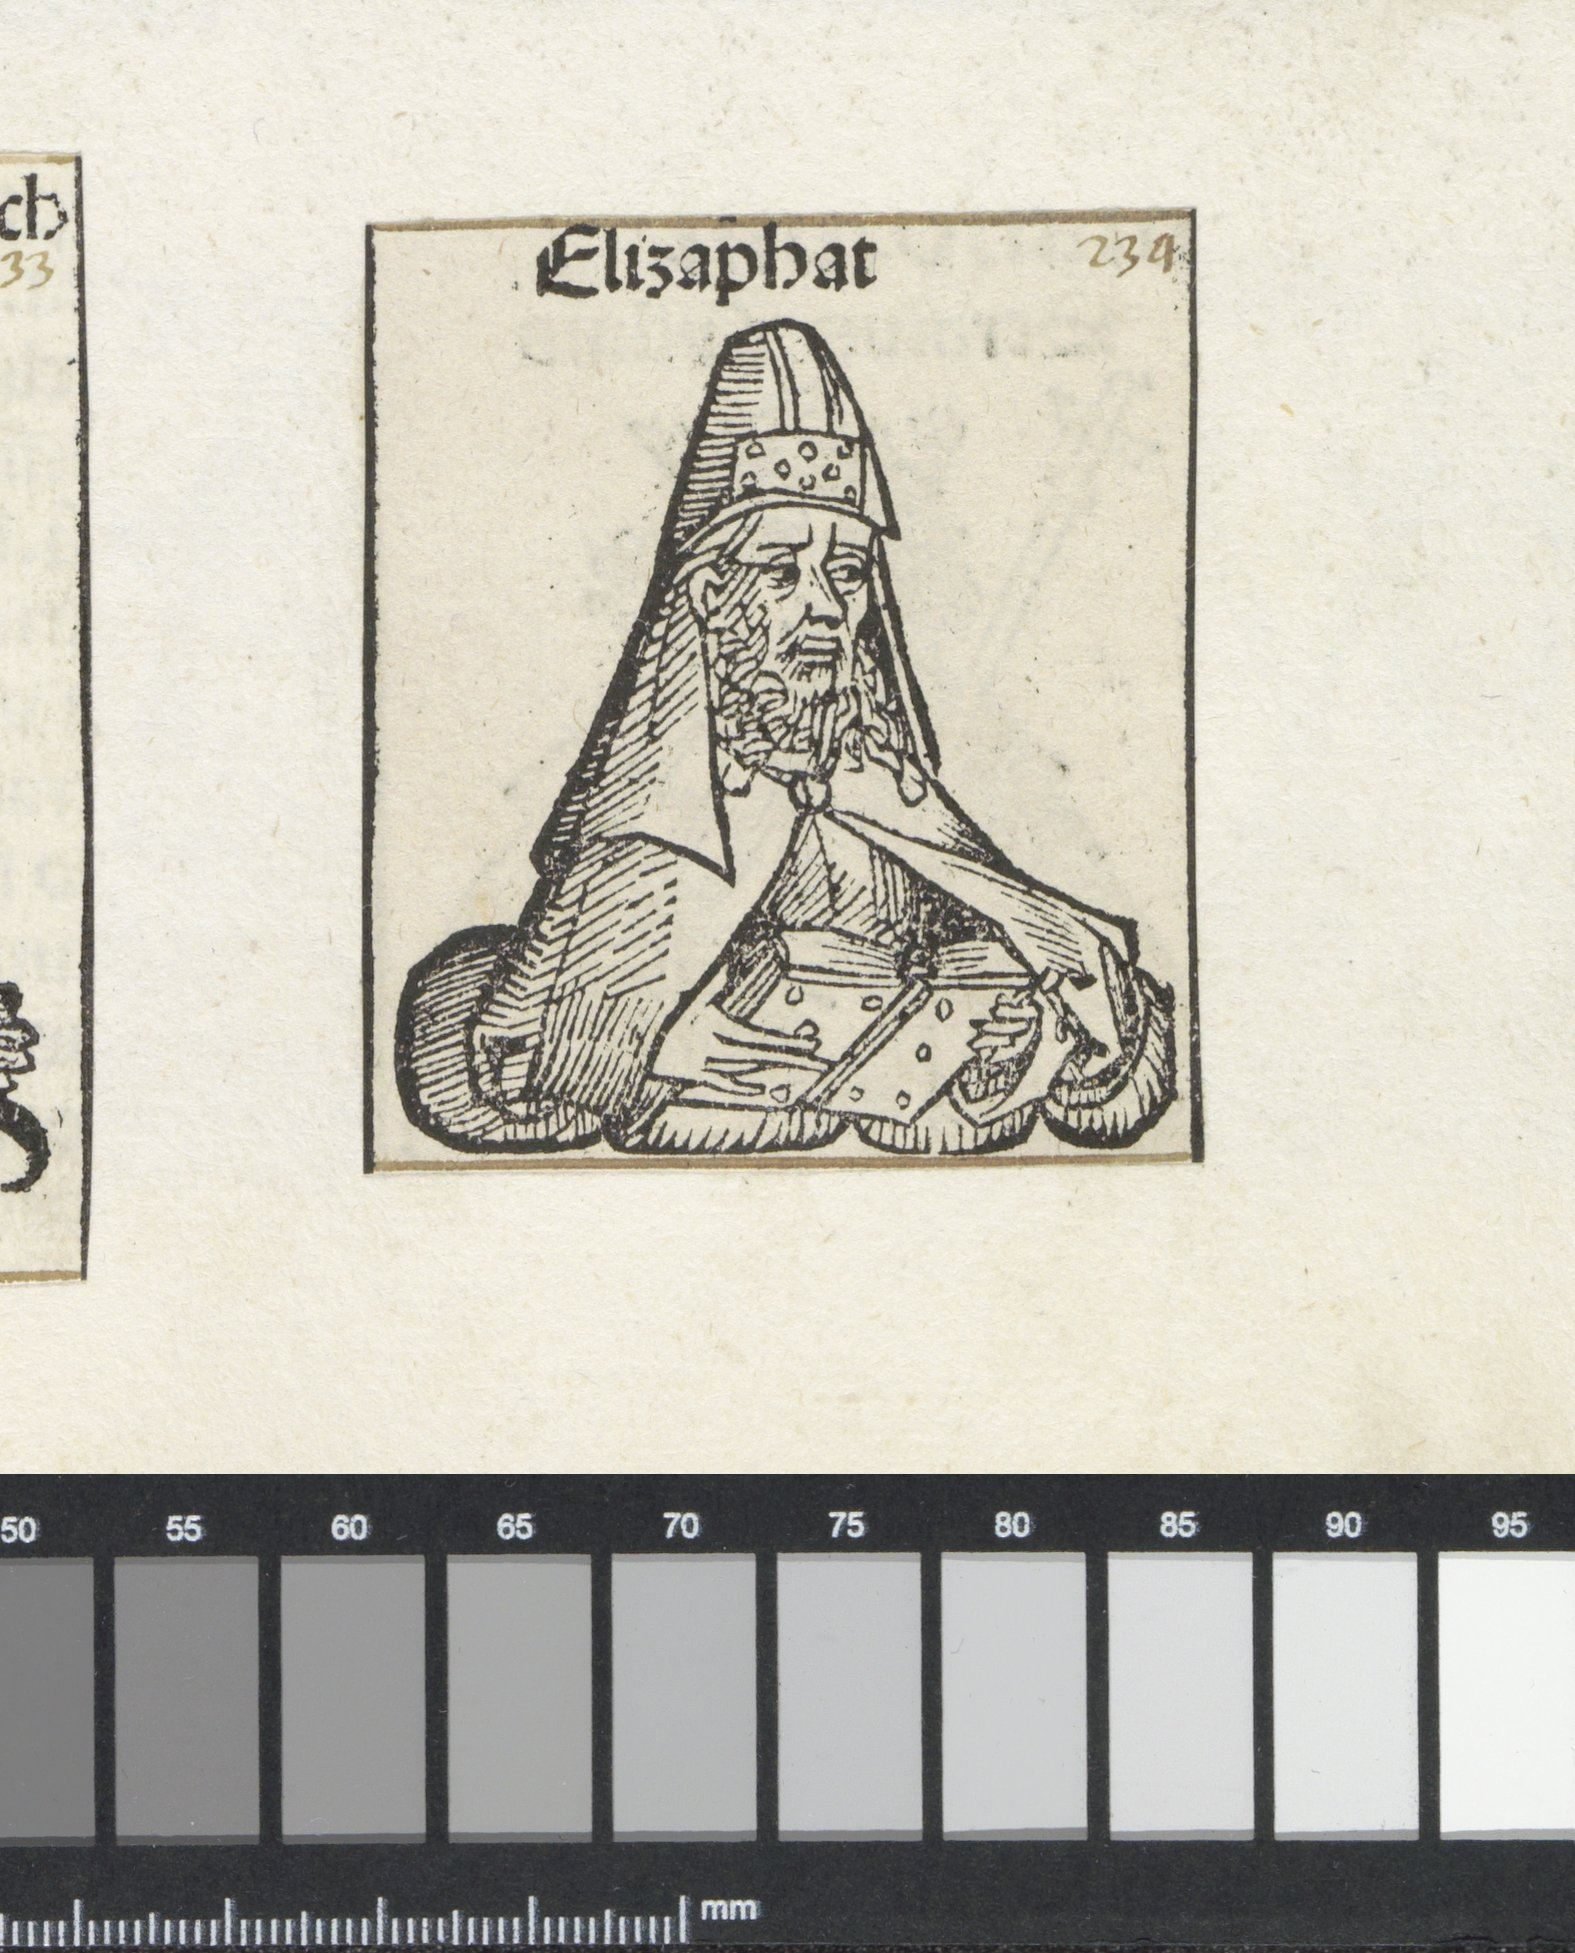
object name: book illustration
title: Elizaphat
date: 1493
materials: paper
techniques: letterpress printing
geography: nuremberg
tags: reading, high priest ~ hierarchy of priests, persons from the old testament (not in biblical context, nor occurring in legendary/historical extensions included in division 71)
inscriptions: inscription: ‘234’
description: Een bloemkelk met een man in priesterkledij. Hij heeft een boek in zijn handen. De tekst identificeert hem als Elzaphat (bedoeld wordt Eljasib), hogepriester en zoon van Jojakim. De voorstelling is onderdeel van de opeenvolging priesters in de Liber Chronicarum. De prent maakt deel uit van een album.